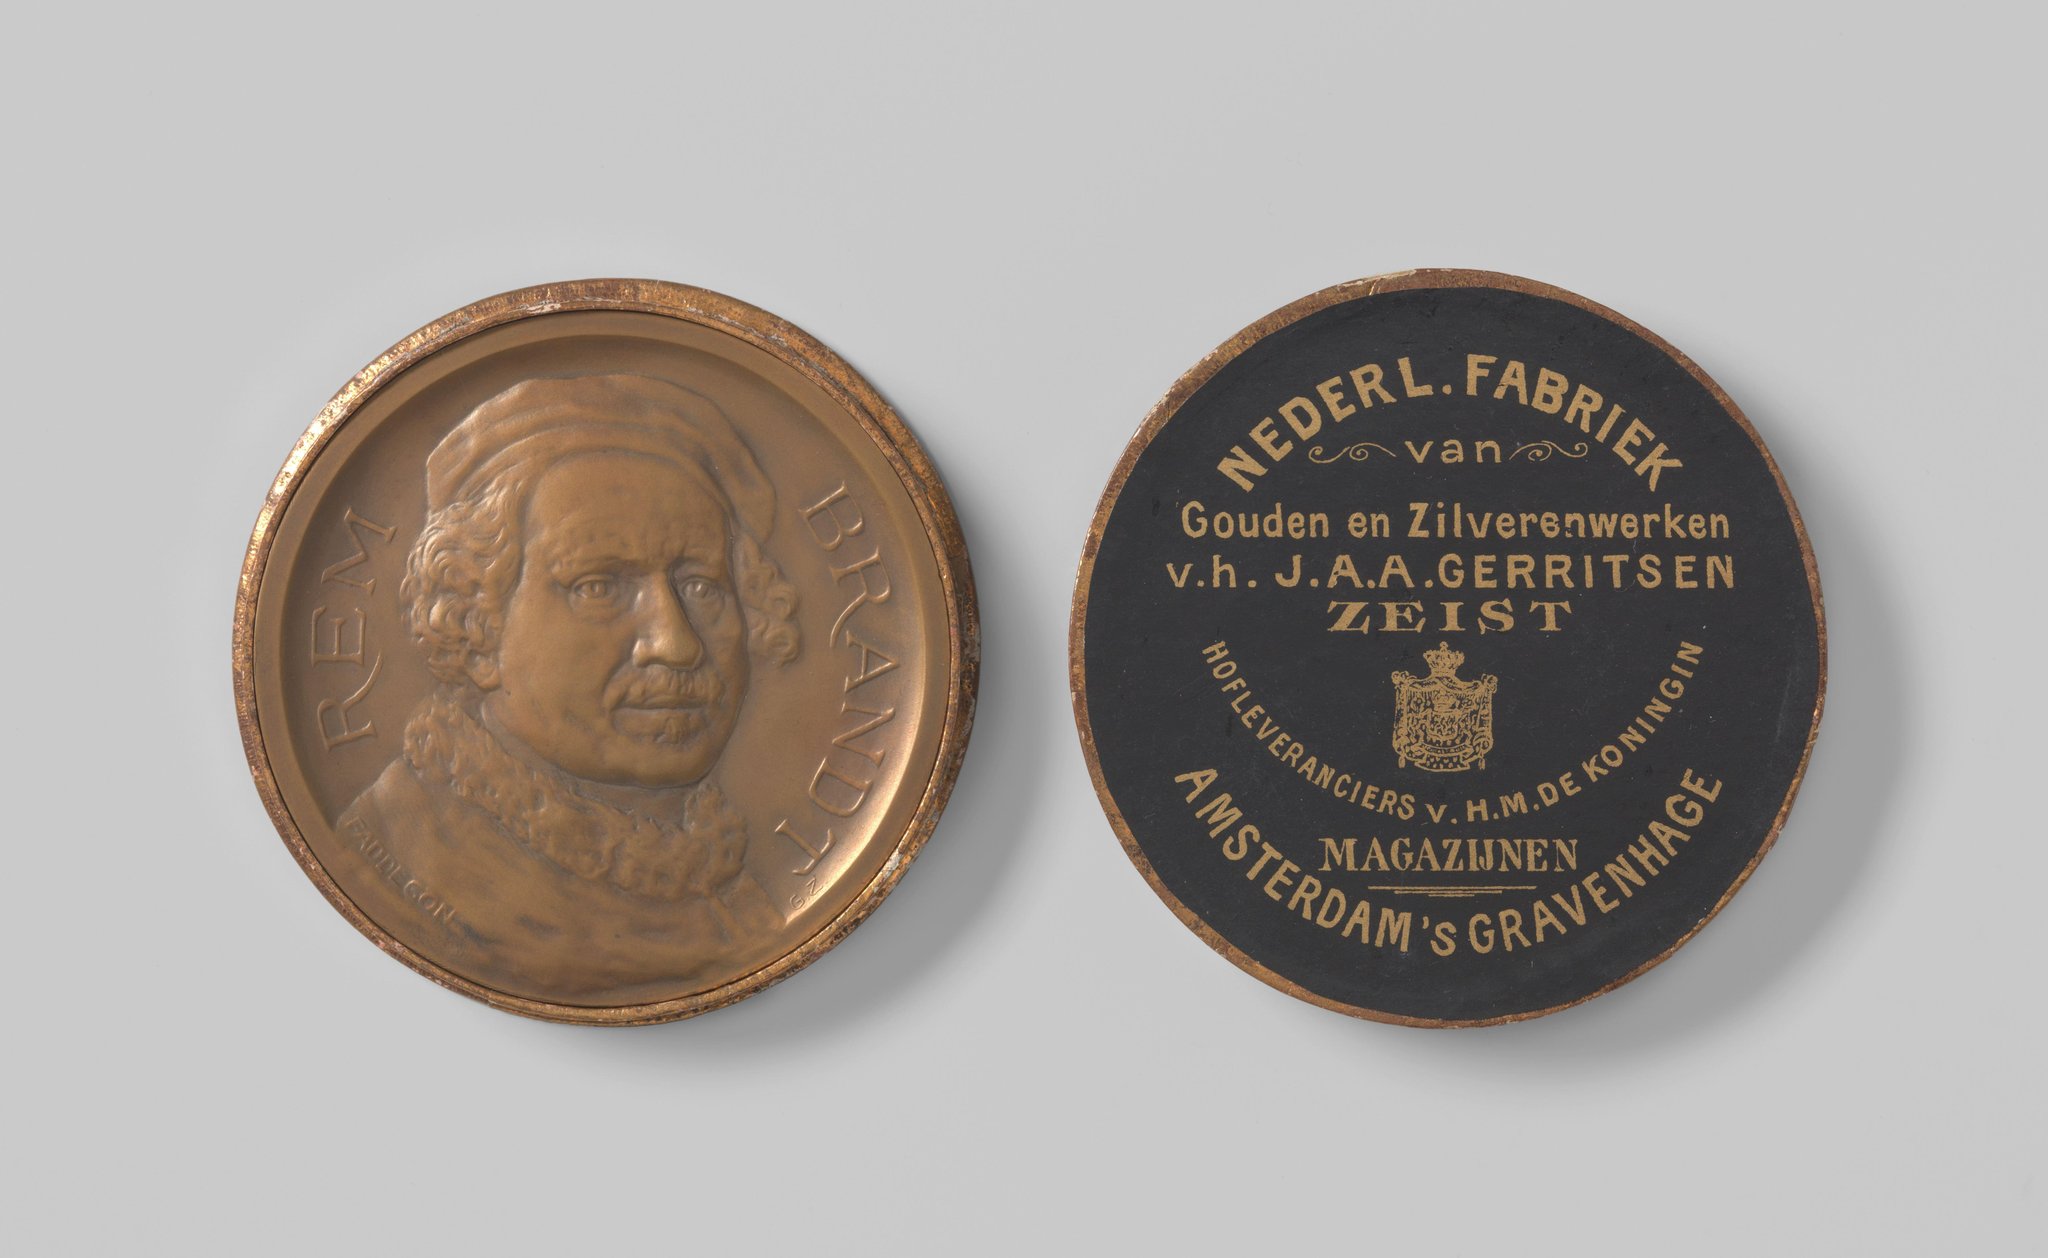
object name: medal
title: Rembrandt-penning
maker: johan melchior faddegon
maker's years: 1871-1941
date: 1906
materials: bronze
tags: leiden, amsterdam, painter, print maker, draughtsman, rembrandt van rijn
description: Rembrandt-penning van brons, J.M. Faddegon, 1906. Met vier voorstudies in gips (BK-1972-110-b-e).